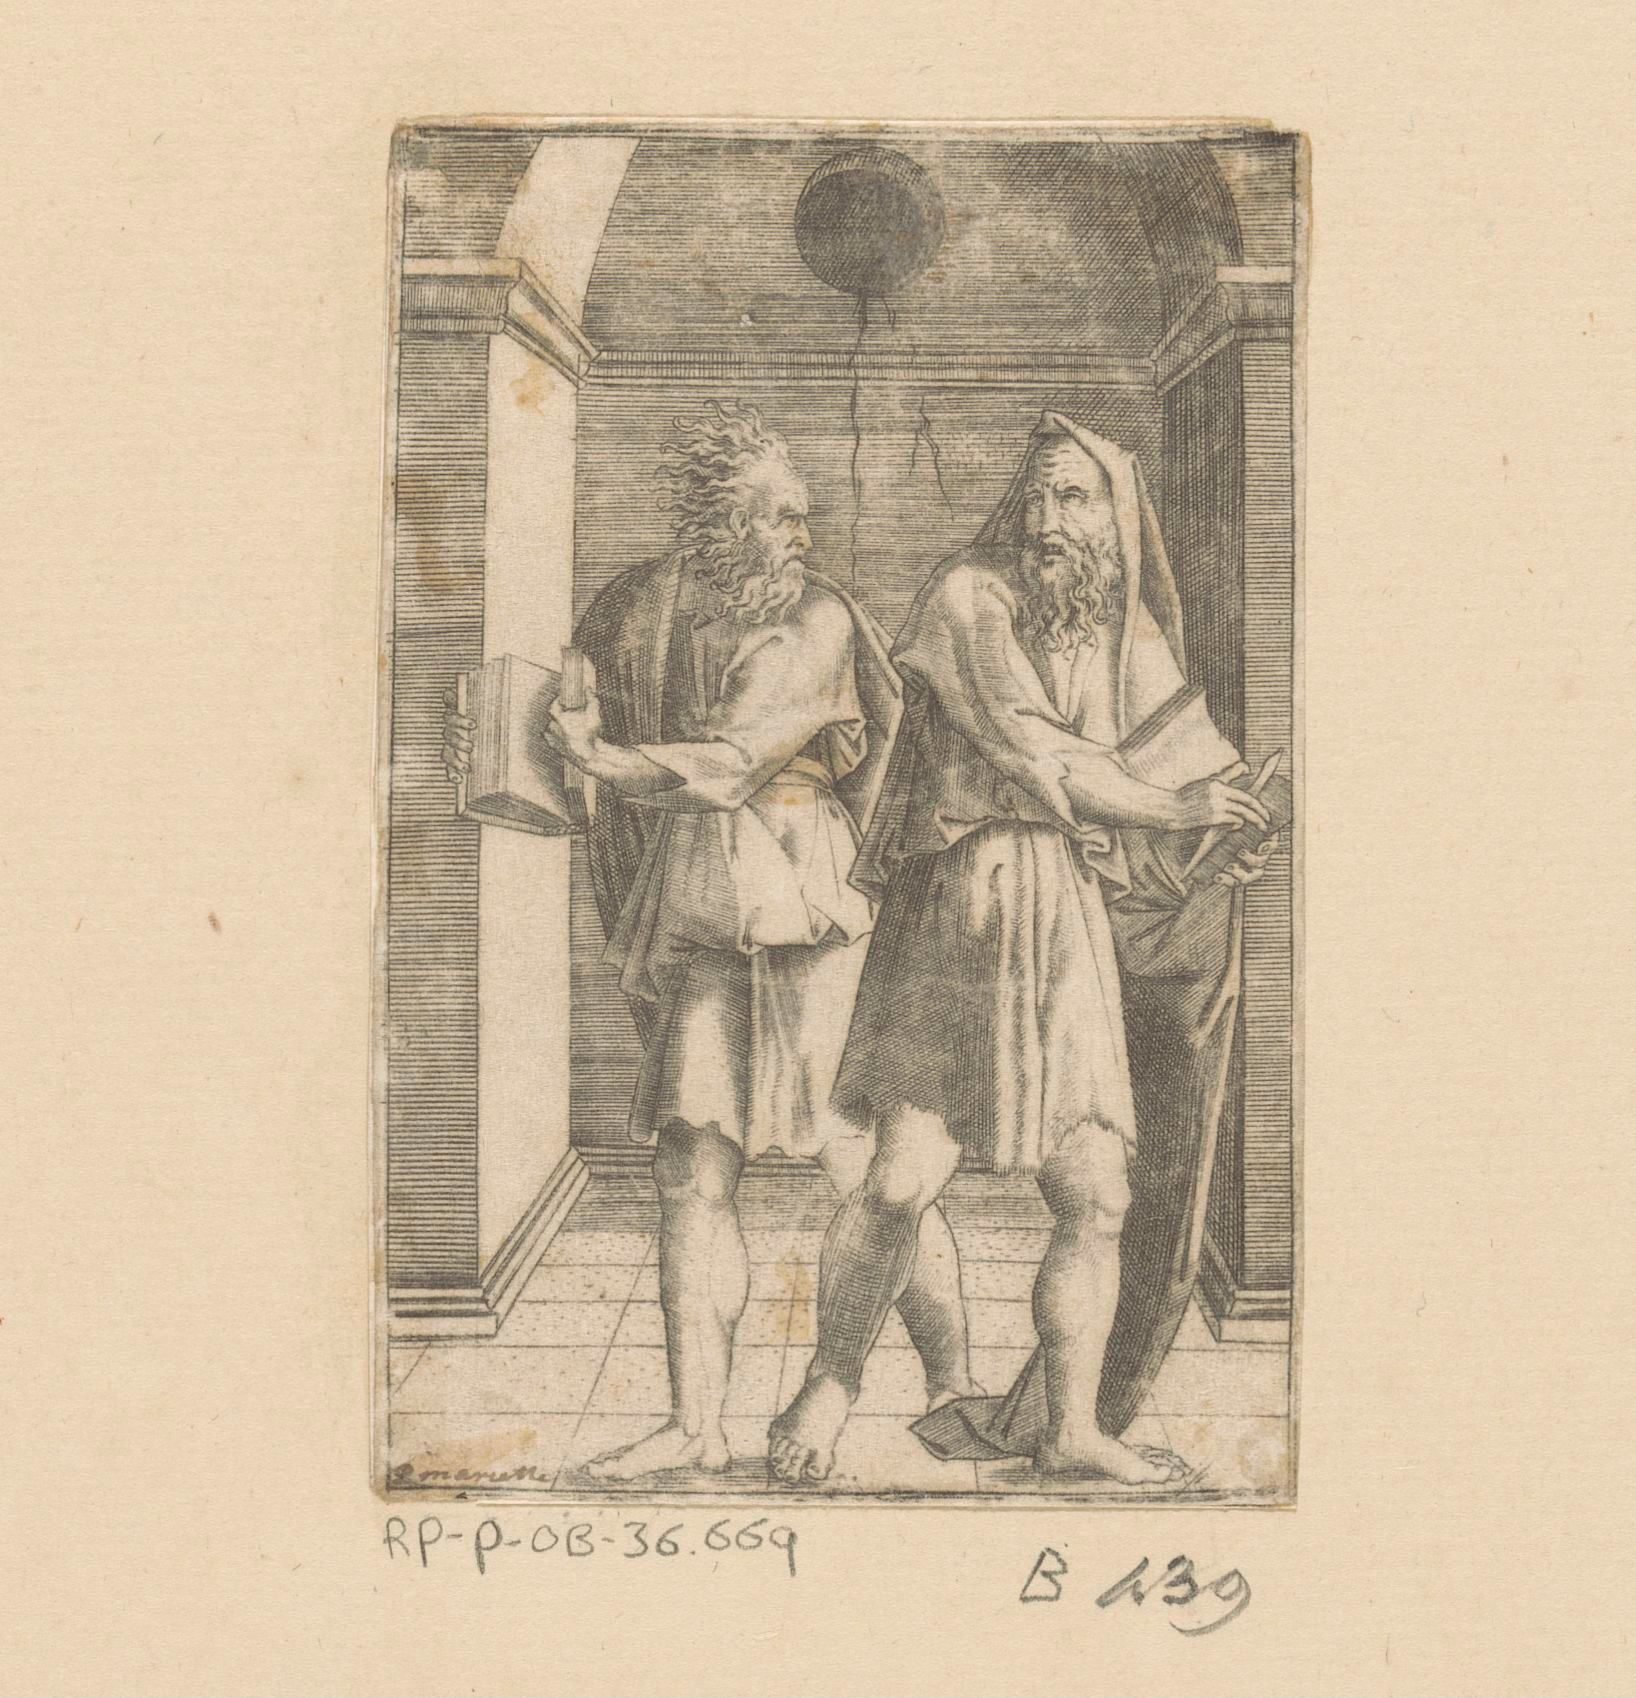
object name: print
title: Twee filosofen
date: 1500-1536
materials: paper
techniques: engraving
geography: italy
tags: group of scholars or philosophers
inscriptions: collector's mark: ‘P mariette’, collector's mark: Lugt 12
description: Twee filosofen staan in onenigheid naast elkaar, beiden een boek in hun handen houdend. Achter hen een nis met bovenaan een oculus.